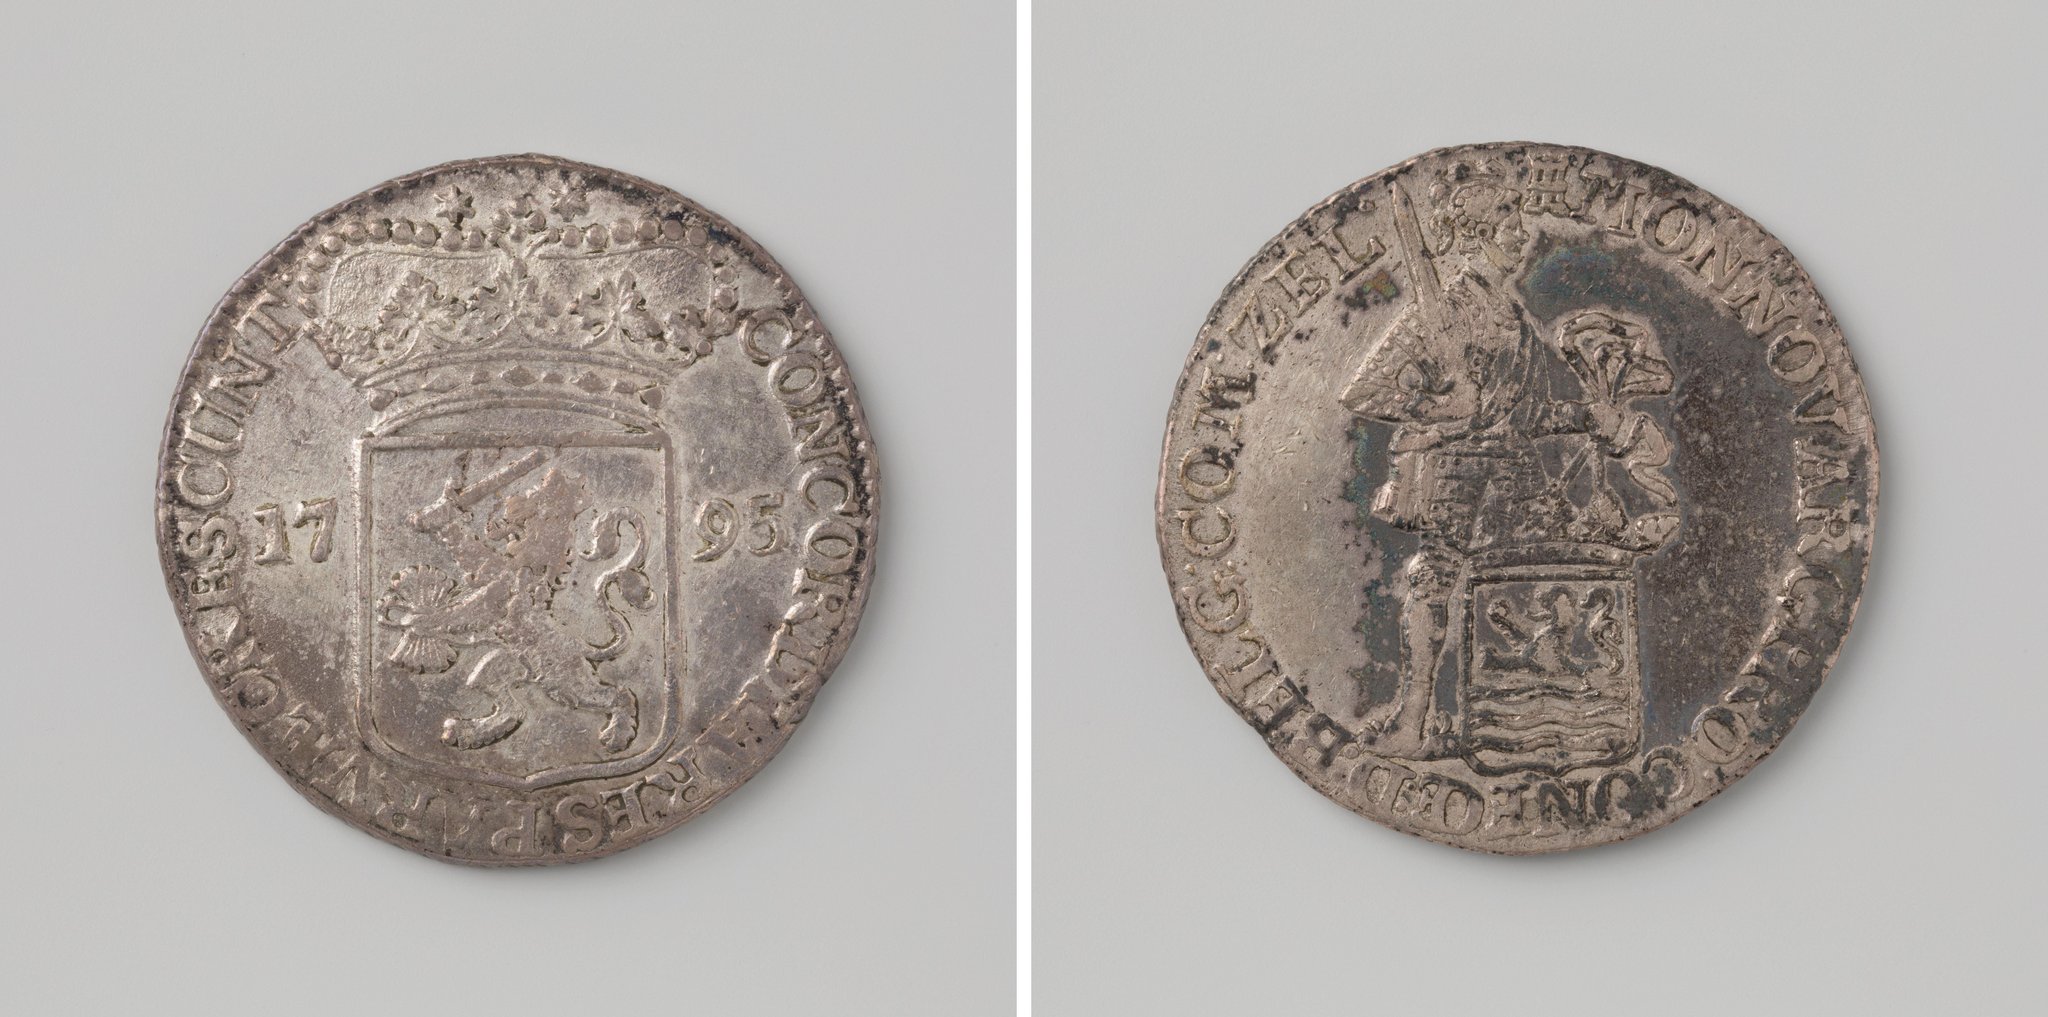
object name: zilveren dukaat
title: Bataafse Republiek, zilveren dukaat op naam van Zeeland, 1795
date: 1795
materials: silver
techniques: striking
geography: middelburg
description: Zilveren munt. Voorzijde: tussen jaartal gekroond generaliteitswapenschild. Keerzijde: staande ridder met zwaard en het gekroonde wapenchild van Zeeland. Kabelrand.